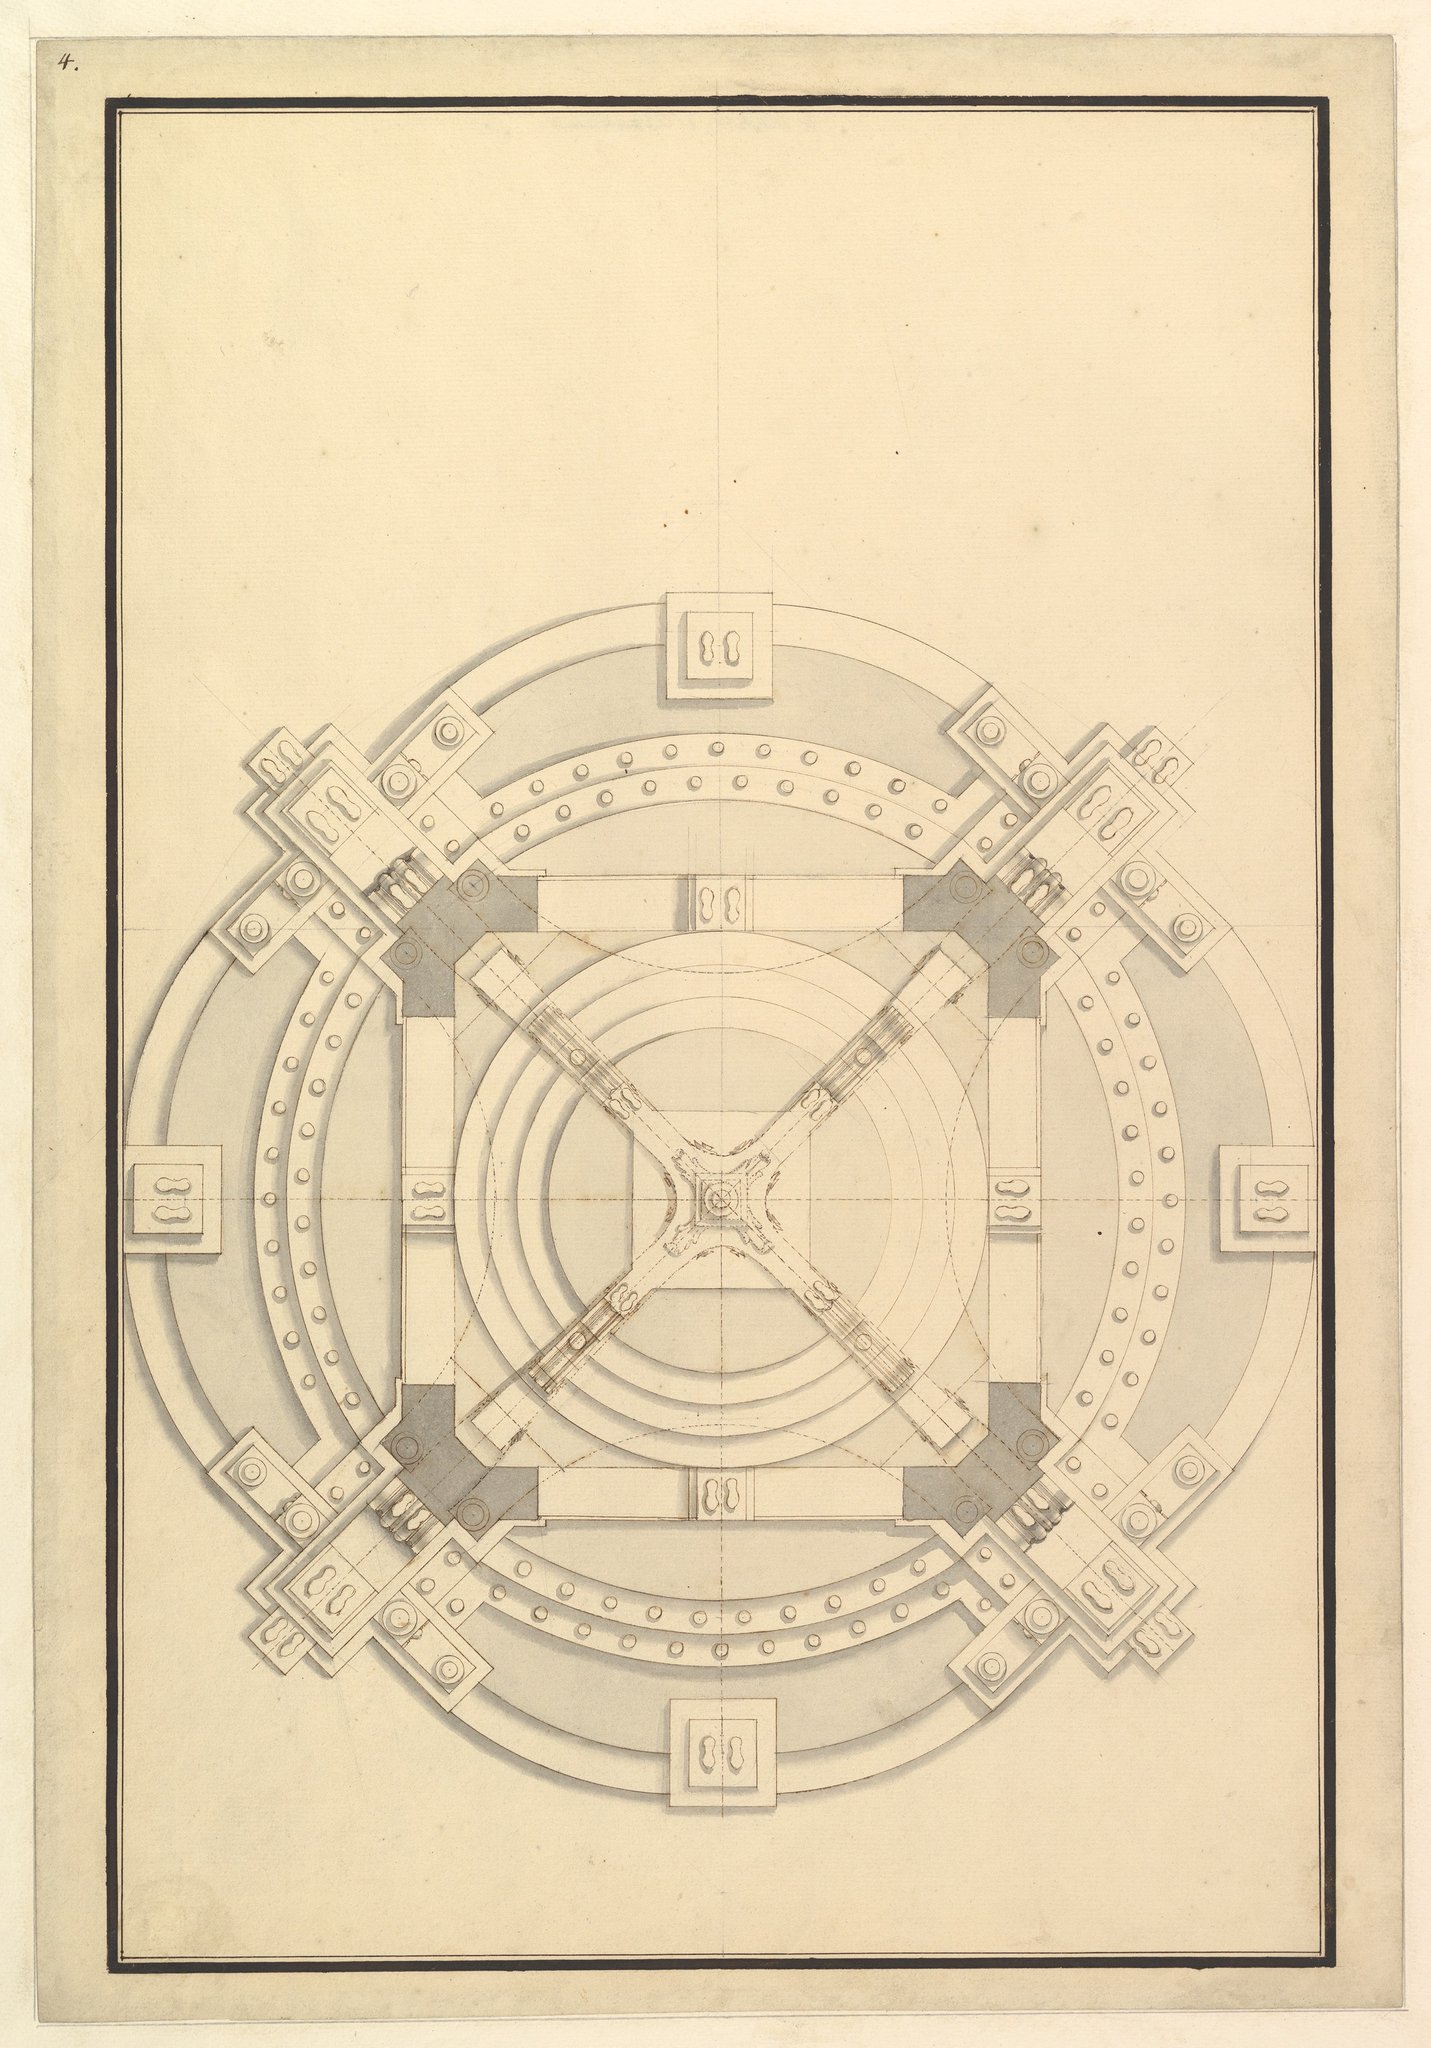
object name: drawing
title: Ground Plan for a Catafalque for an electress of Bavaria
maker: giuseppe galli bibiena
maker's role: artist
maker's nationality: italian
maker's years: 1696-1756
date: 1696-1756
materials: ink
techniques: pen, wash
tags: architecture